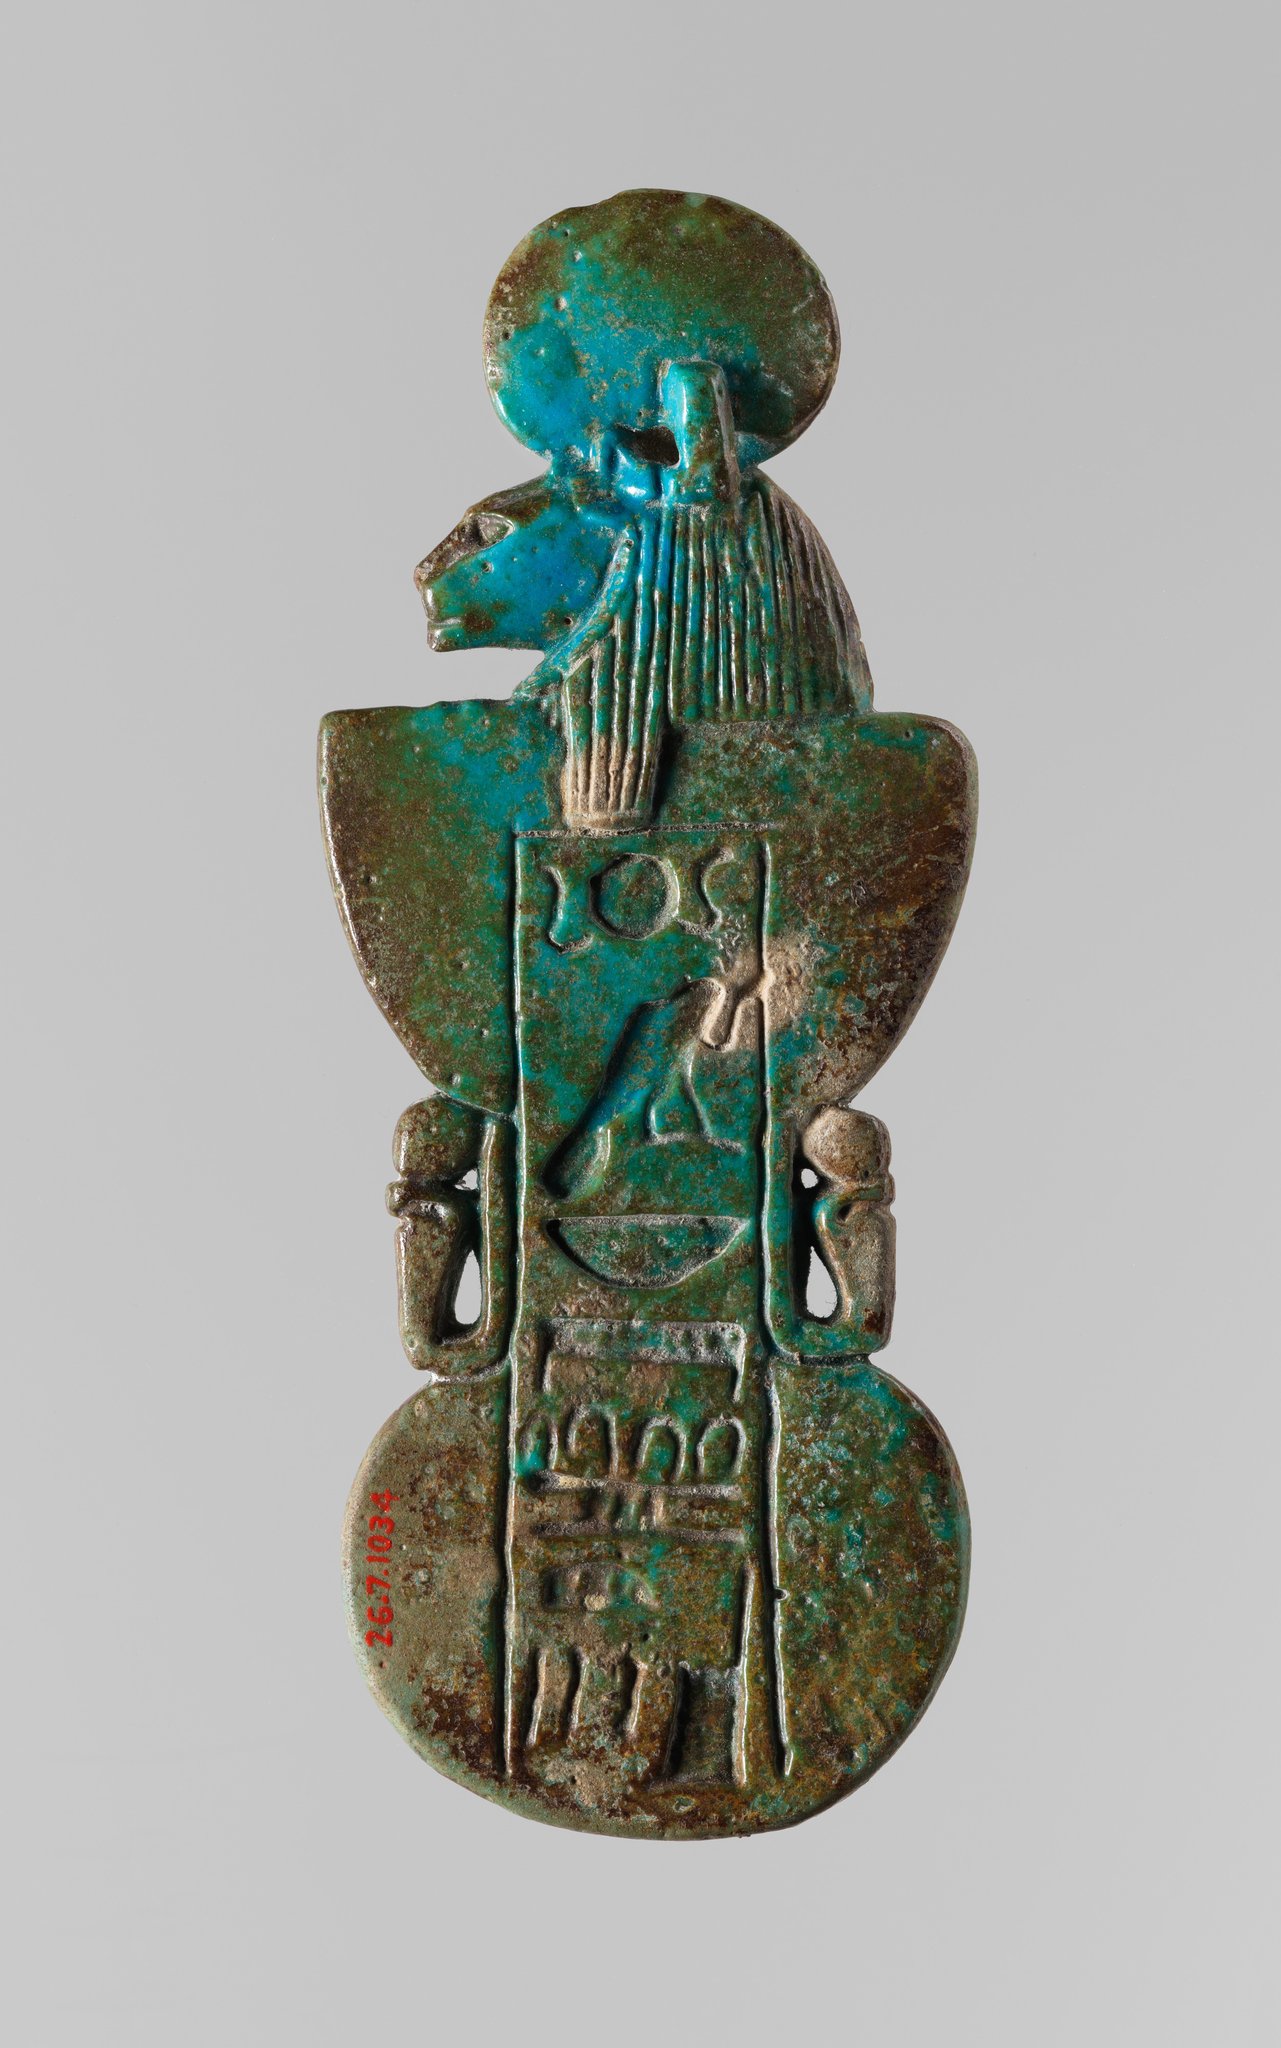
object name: menat counterpoise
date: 1070-664 BCE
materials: faience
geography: egypt